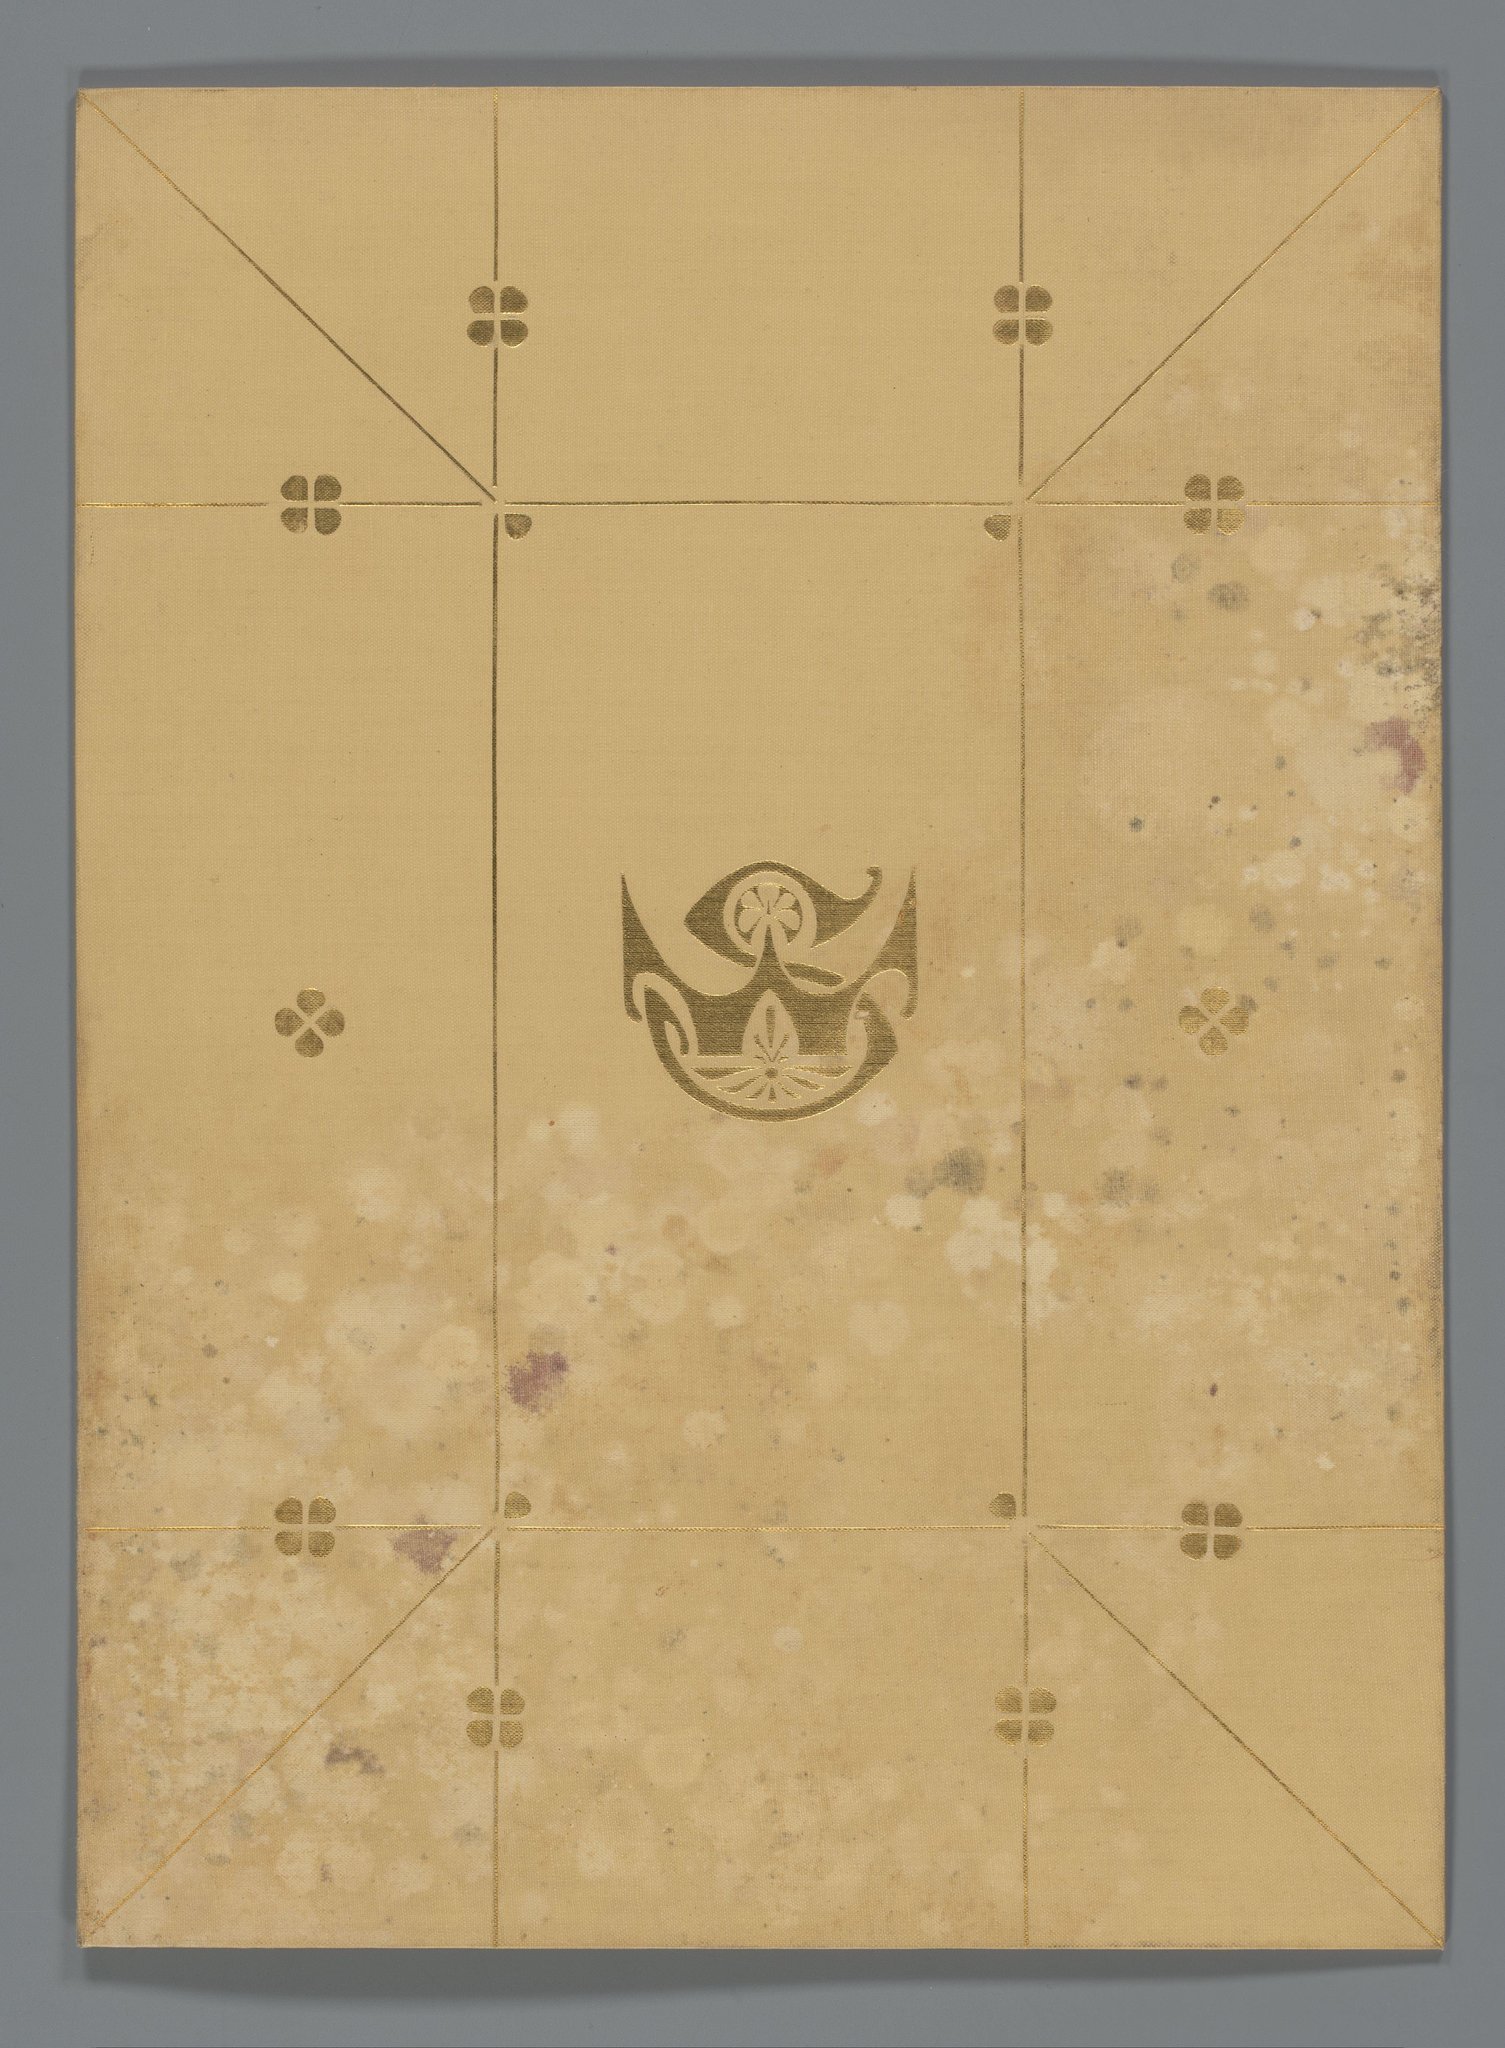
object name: binding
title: Band voor een album voor Prof. Willem Stoeder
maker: Anonymous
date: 1901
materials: cardboard, linen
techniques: gold embossing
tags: utrecht, amsterdam, magic mathematical figures; magic numbers, words, monograms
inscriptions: collector's mark: ‘R:MVS.’, annotation: ‘band van album./ Prof W. Stoeder’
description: Proefband van een album voor Prof. Willem Stoeder ter gelegenheid van diens afscheid als hoogleraar artsenijbereidkunde aan de Universiteit van Amsterdam.